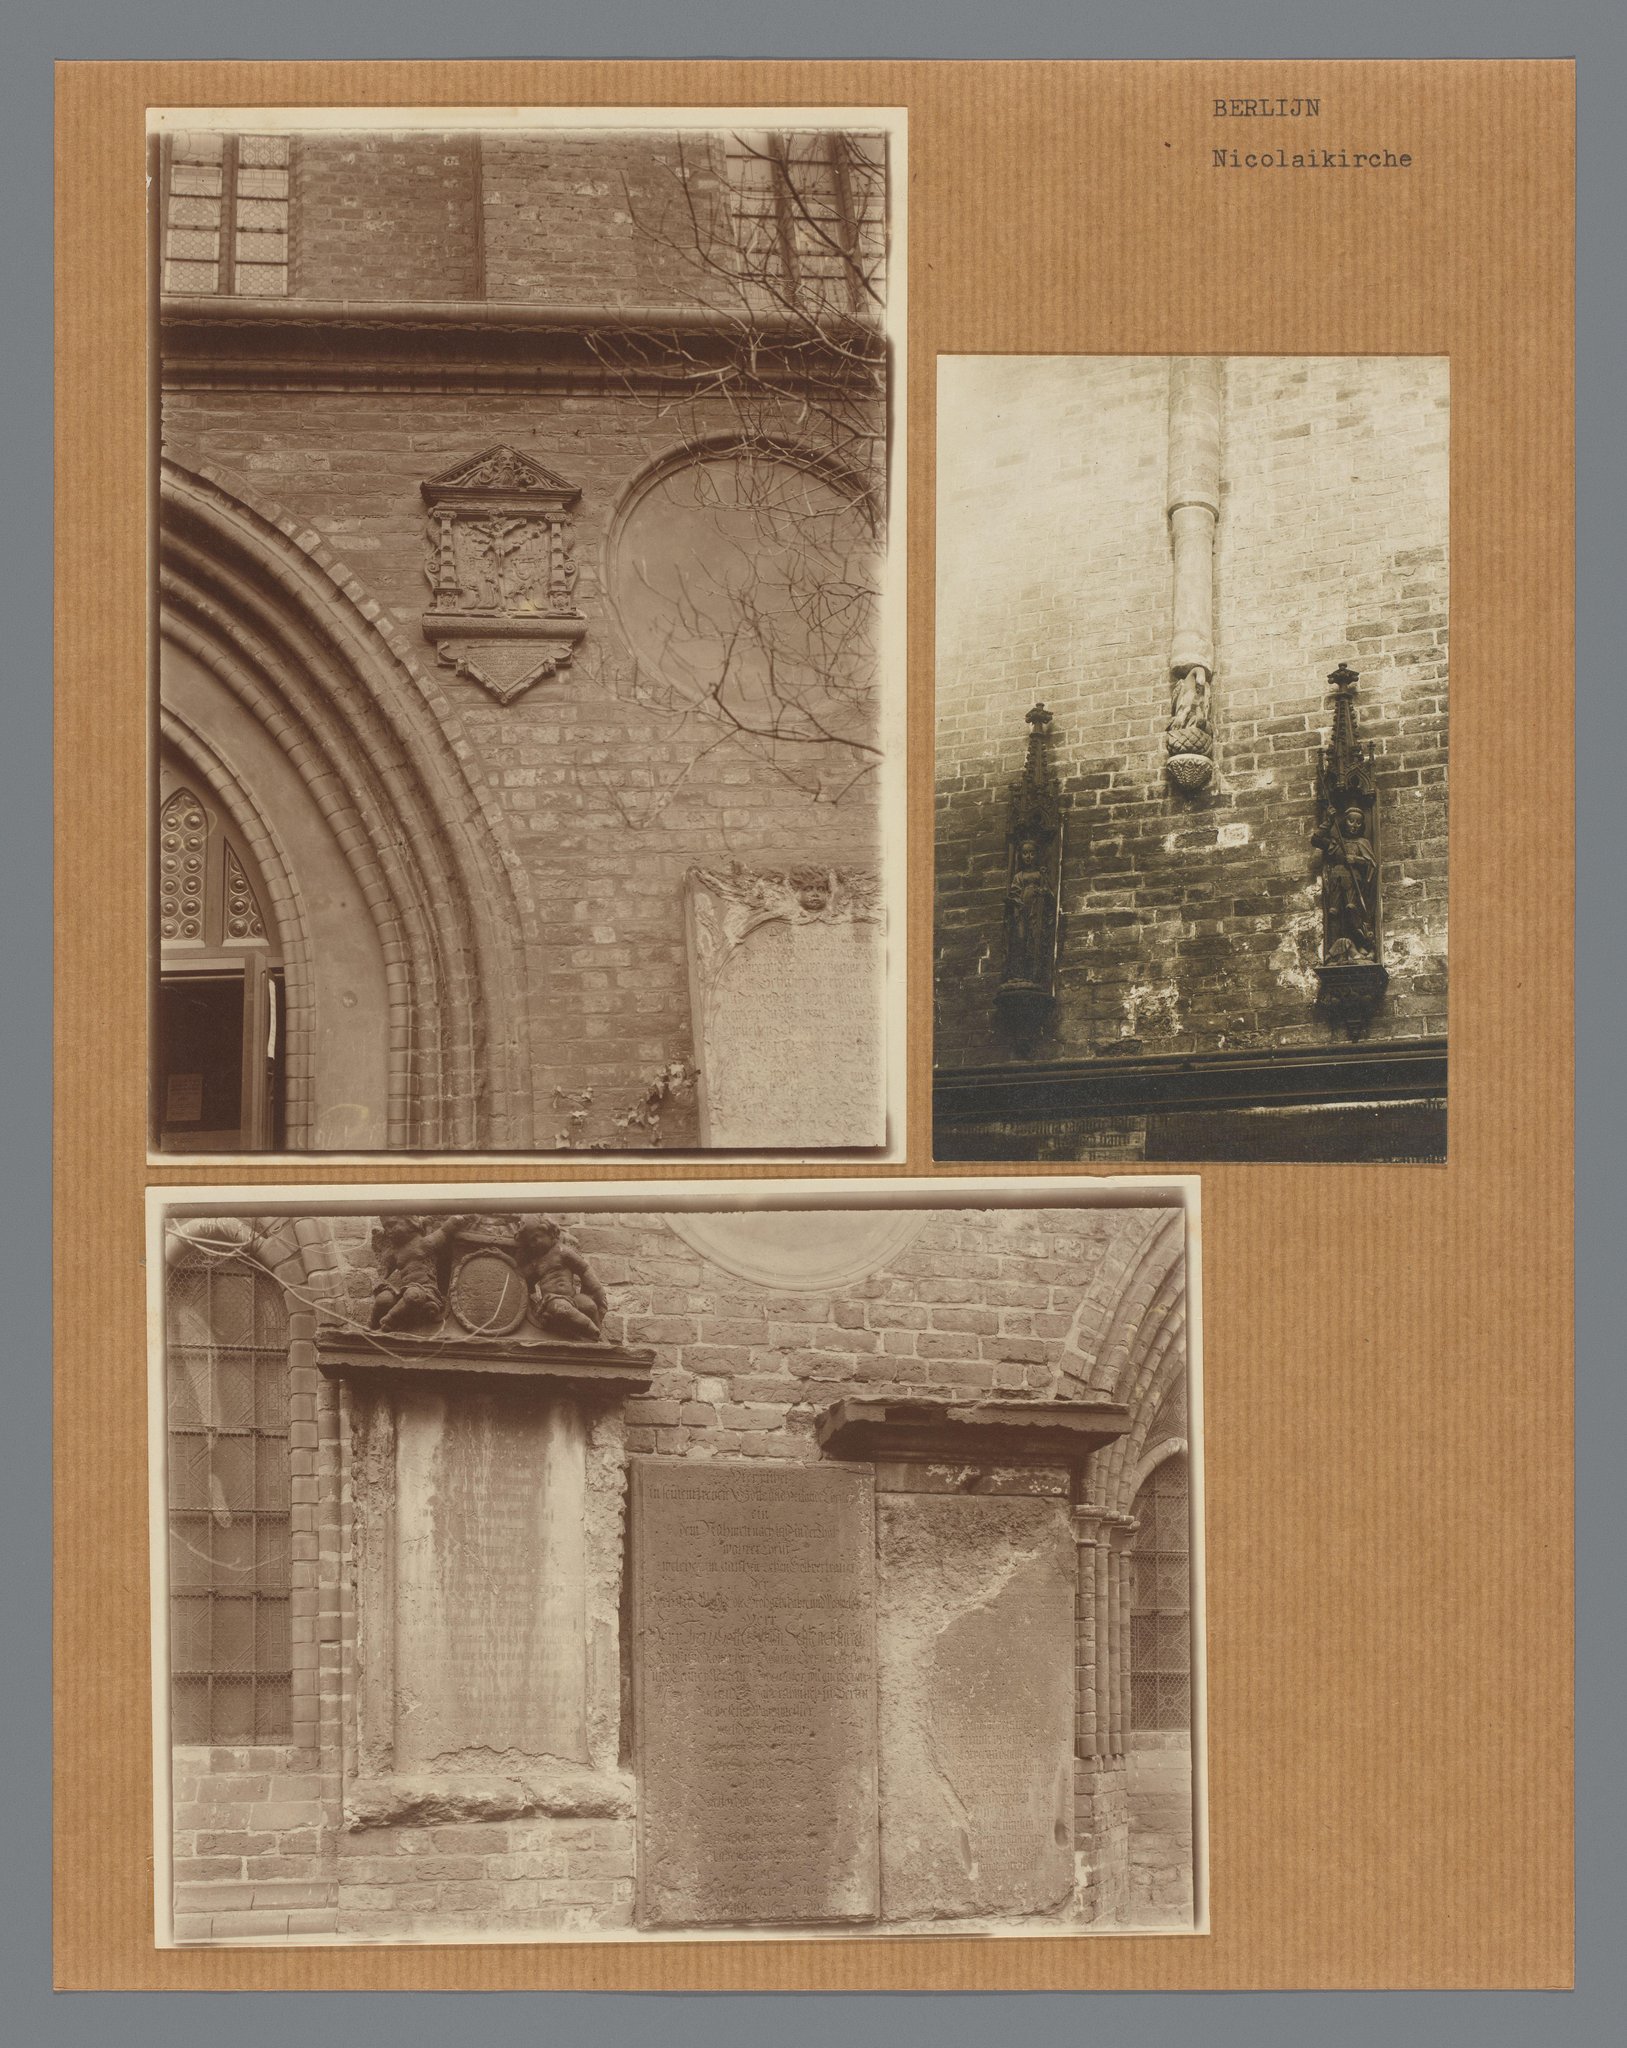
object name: photograph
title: Berlijn. Nicolaikirche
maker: Anonymous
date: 1880-1920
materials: photographic support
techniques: gelatin silver print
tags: berlin